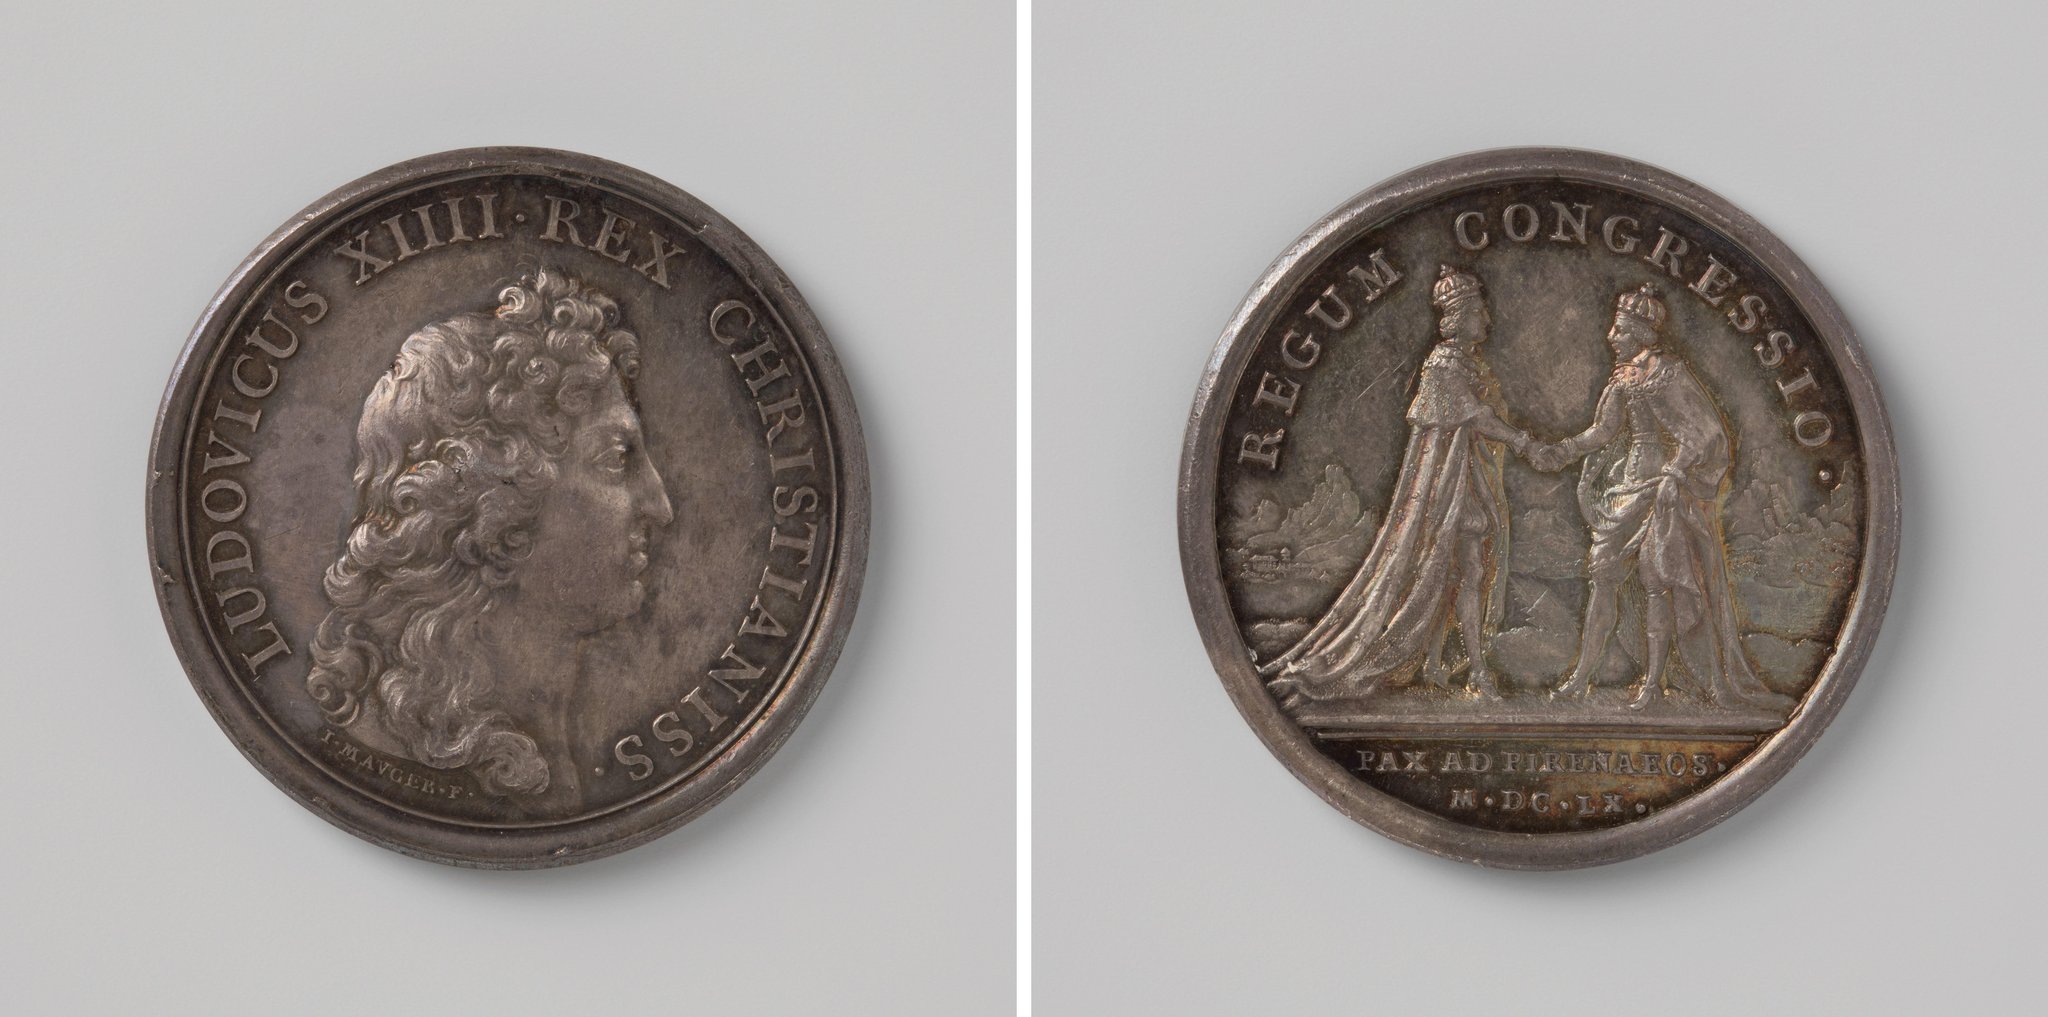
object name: history medal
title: Vrede van de Pyreneen, op de ontmoeting tussen de Franse en de Spaanse koning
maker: jean mauger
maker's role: medailleur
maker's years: 1648-1722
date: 1699-1703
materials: silver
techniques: striking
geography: paris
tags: filips iv (koning van spanje), lodewijk xiv (koning van frankrijk), france, spain